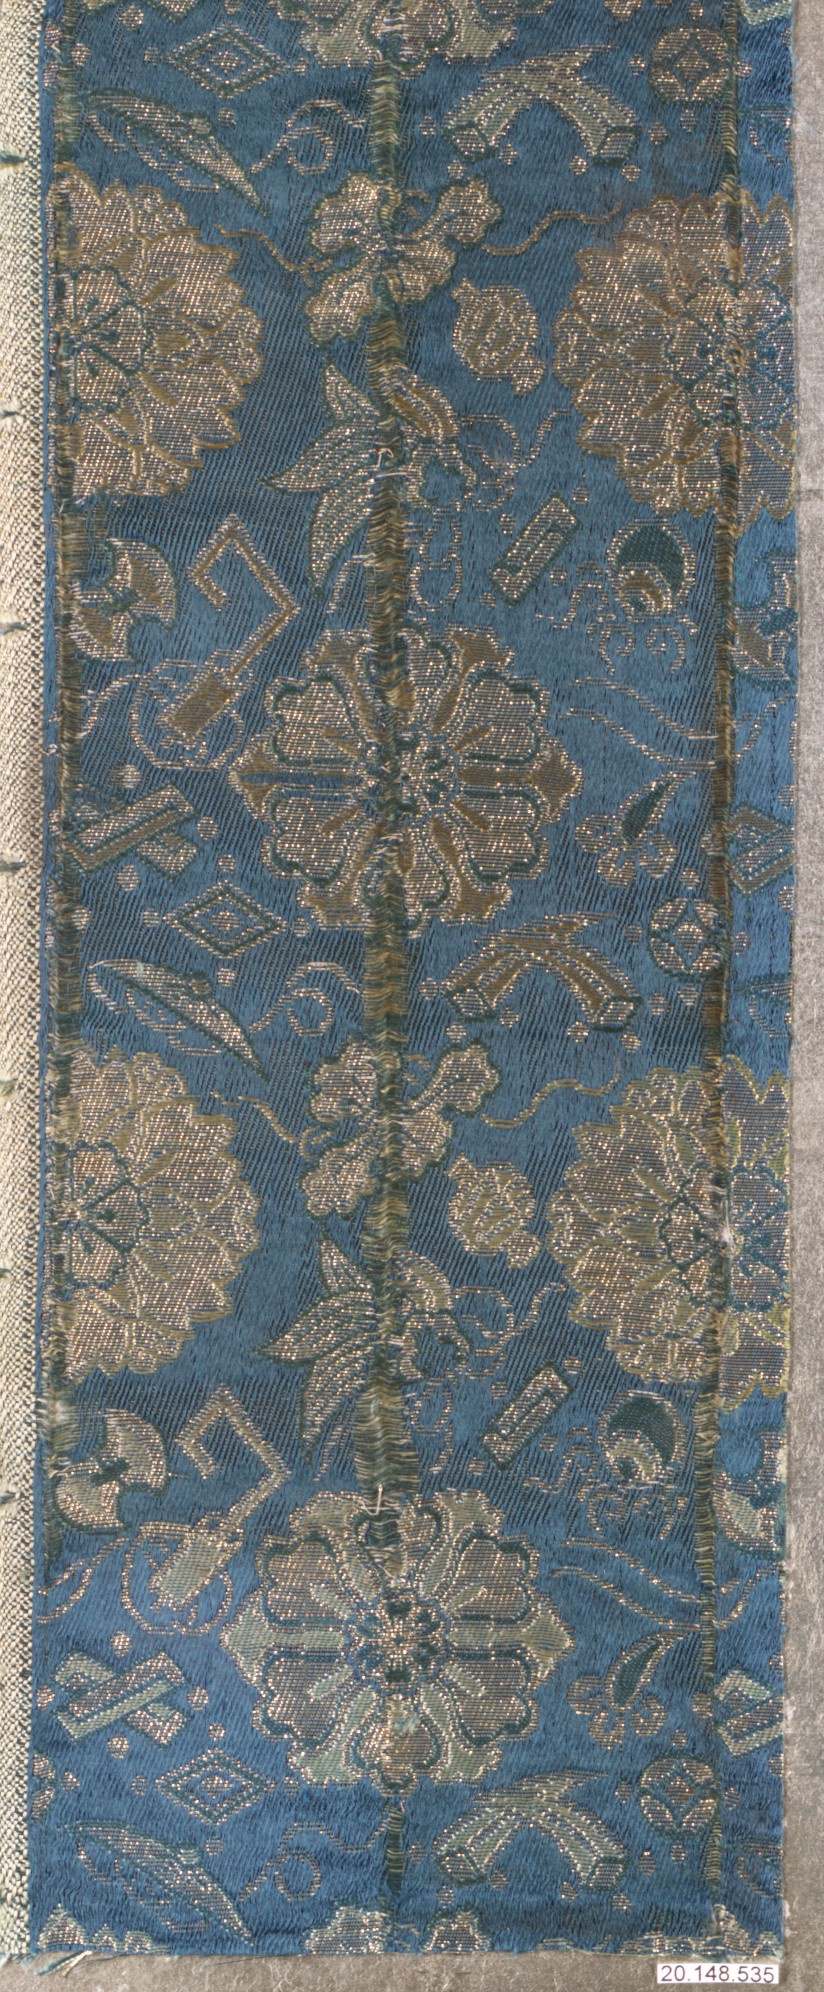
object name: piece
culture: japanese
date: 1701-1800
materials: silk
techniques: compound weave